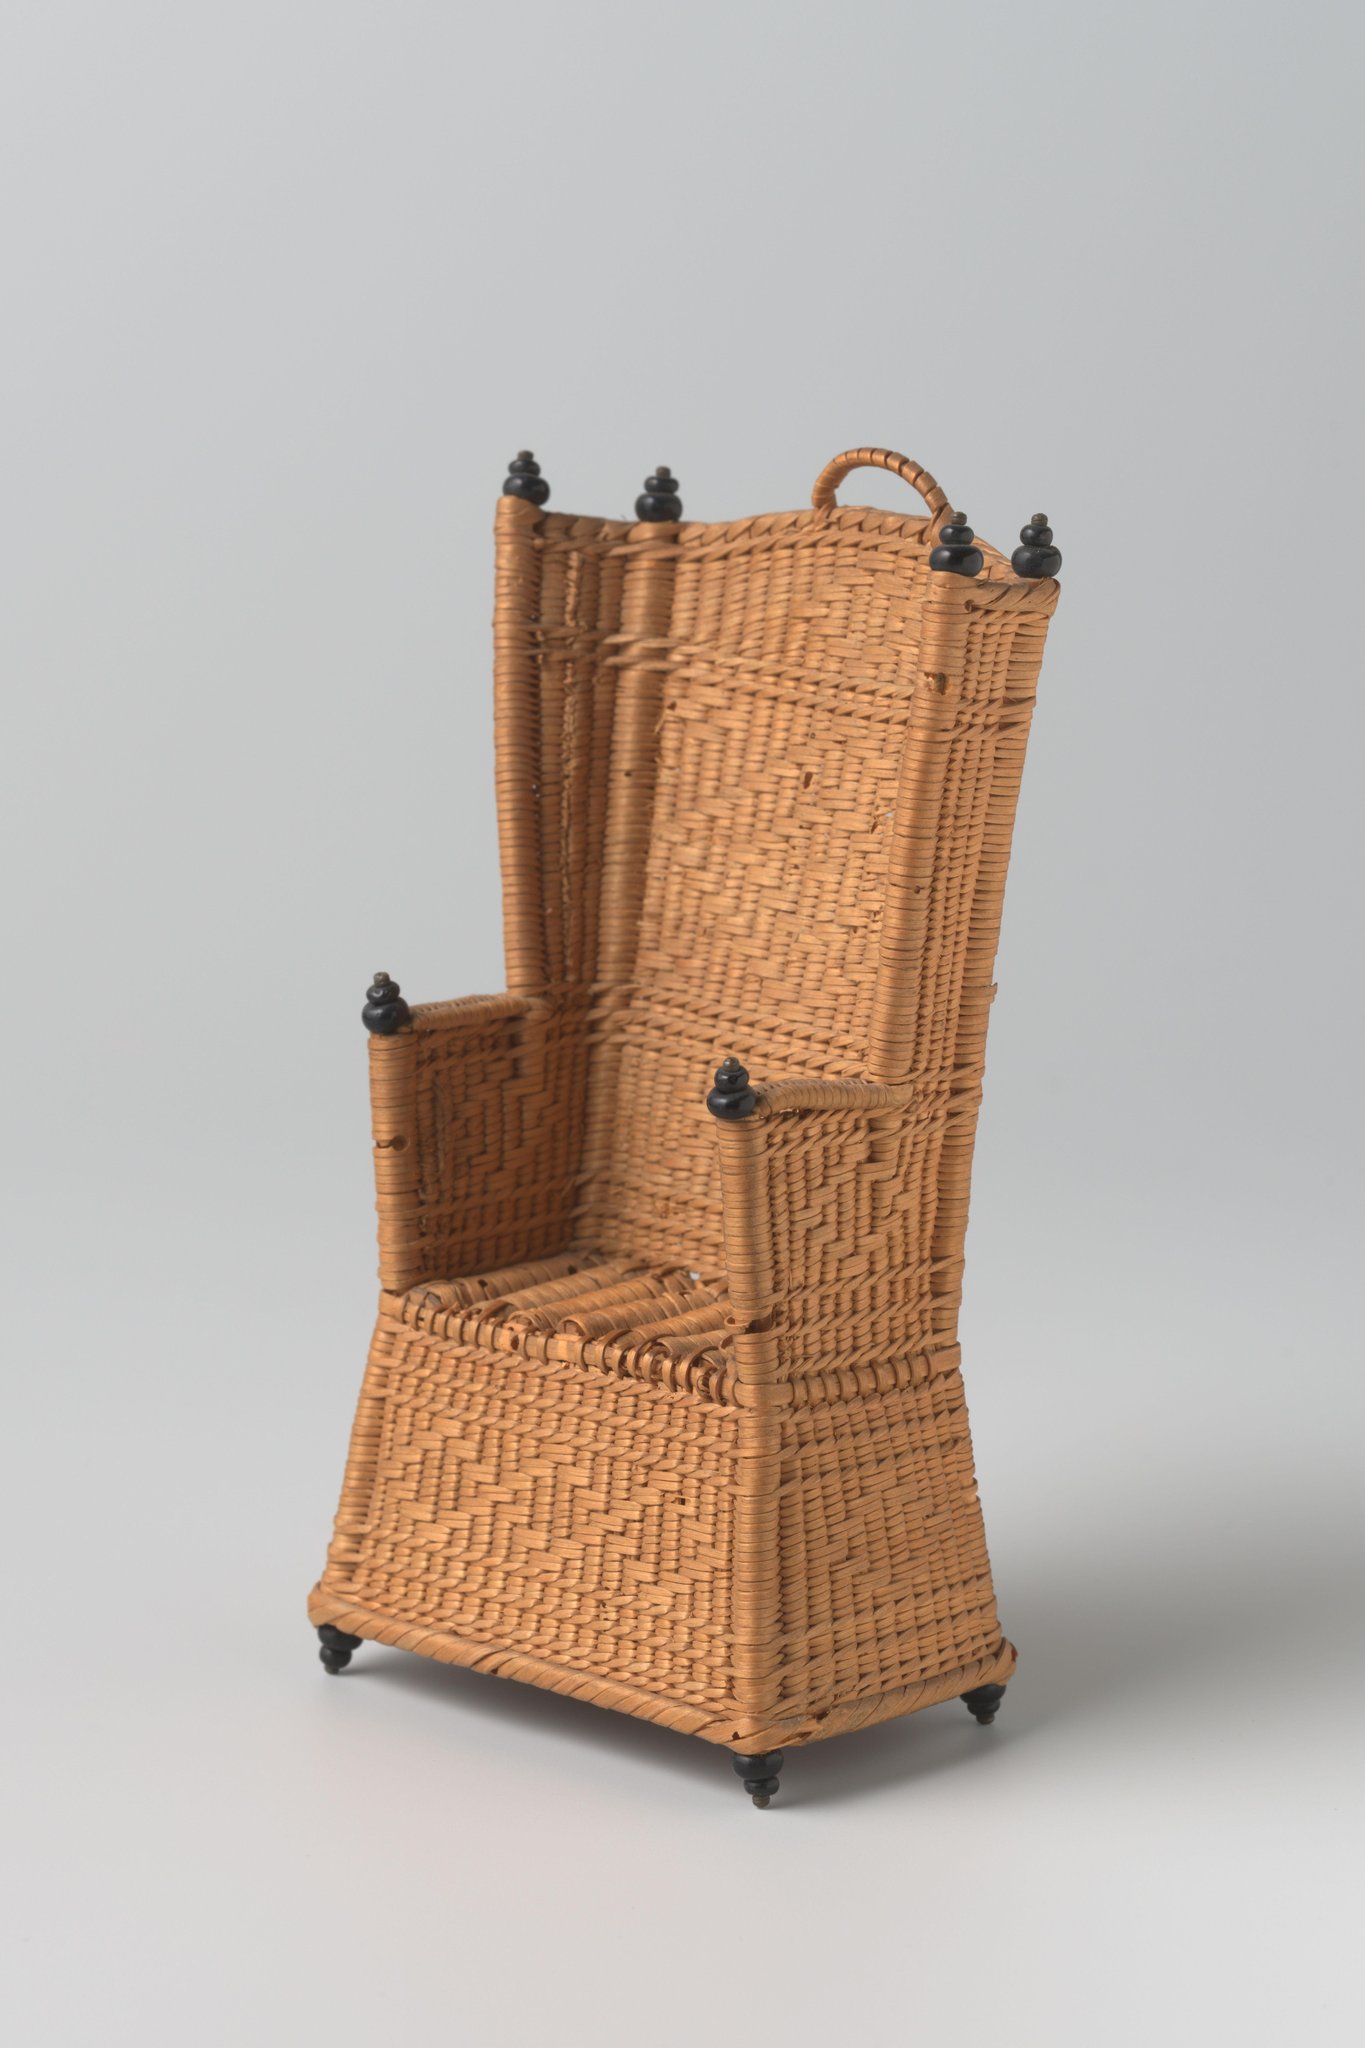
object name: garden machine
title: Ziekenstoel van gevlochten wilgenteen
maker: Anonymous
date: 1676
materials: glass, metal, plant material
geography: halle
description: De stoel is gevlochten van gespleten wilgenteen in de techniek van het fijnscheenwerk. In de wanden zijn ter versiering ruitmotieven gevlochten. De voor- en achterstijlen en de stijlen van de zijwangen eindigen in knoppen van zwarte glaskralen, die er met een speld op zijn vastgepind. De vier bolpootjes bestaan elk uit twee zwarte kralen.